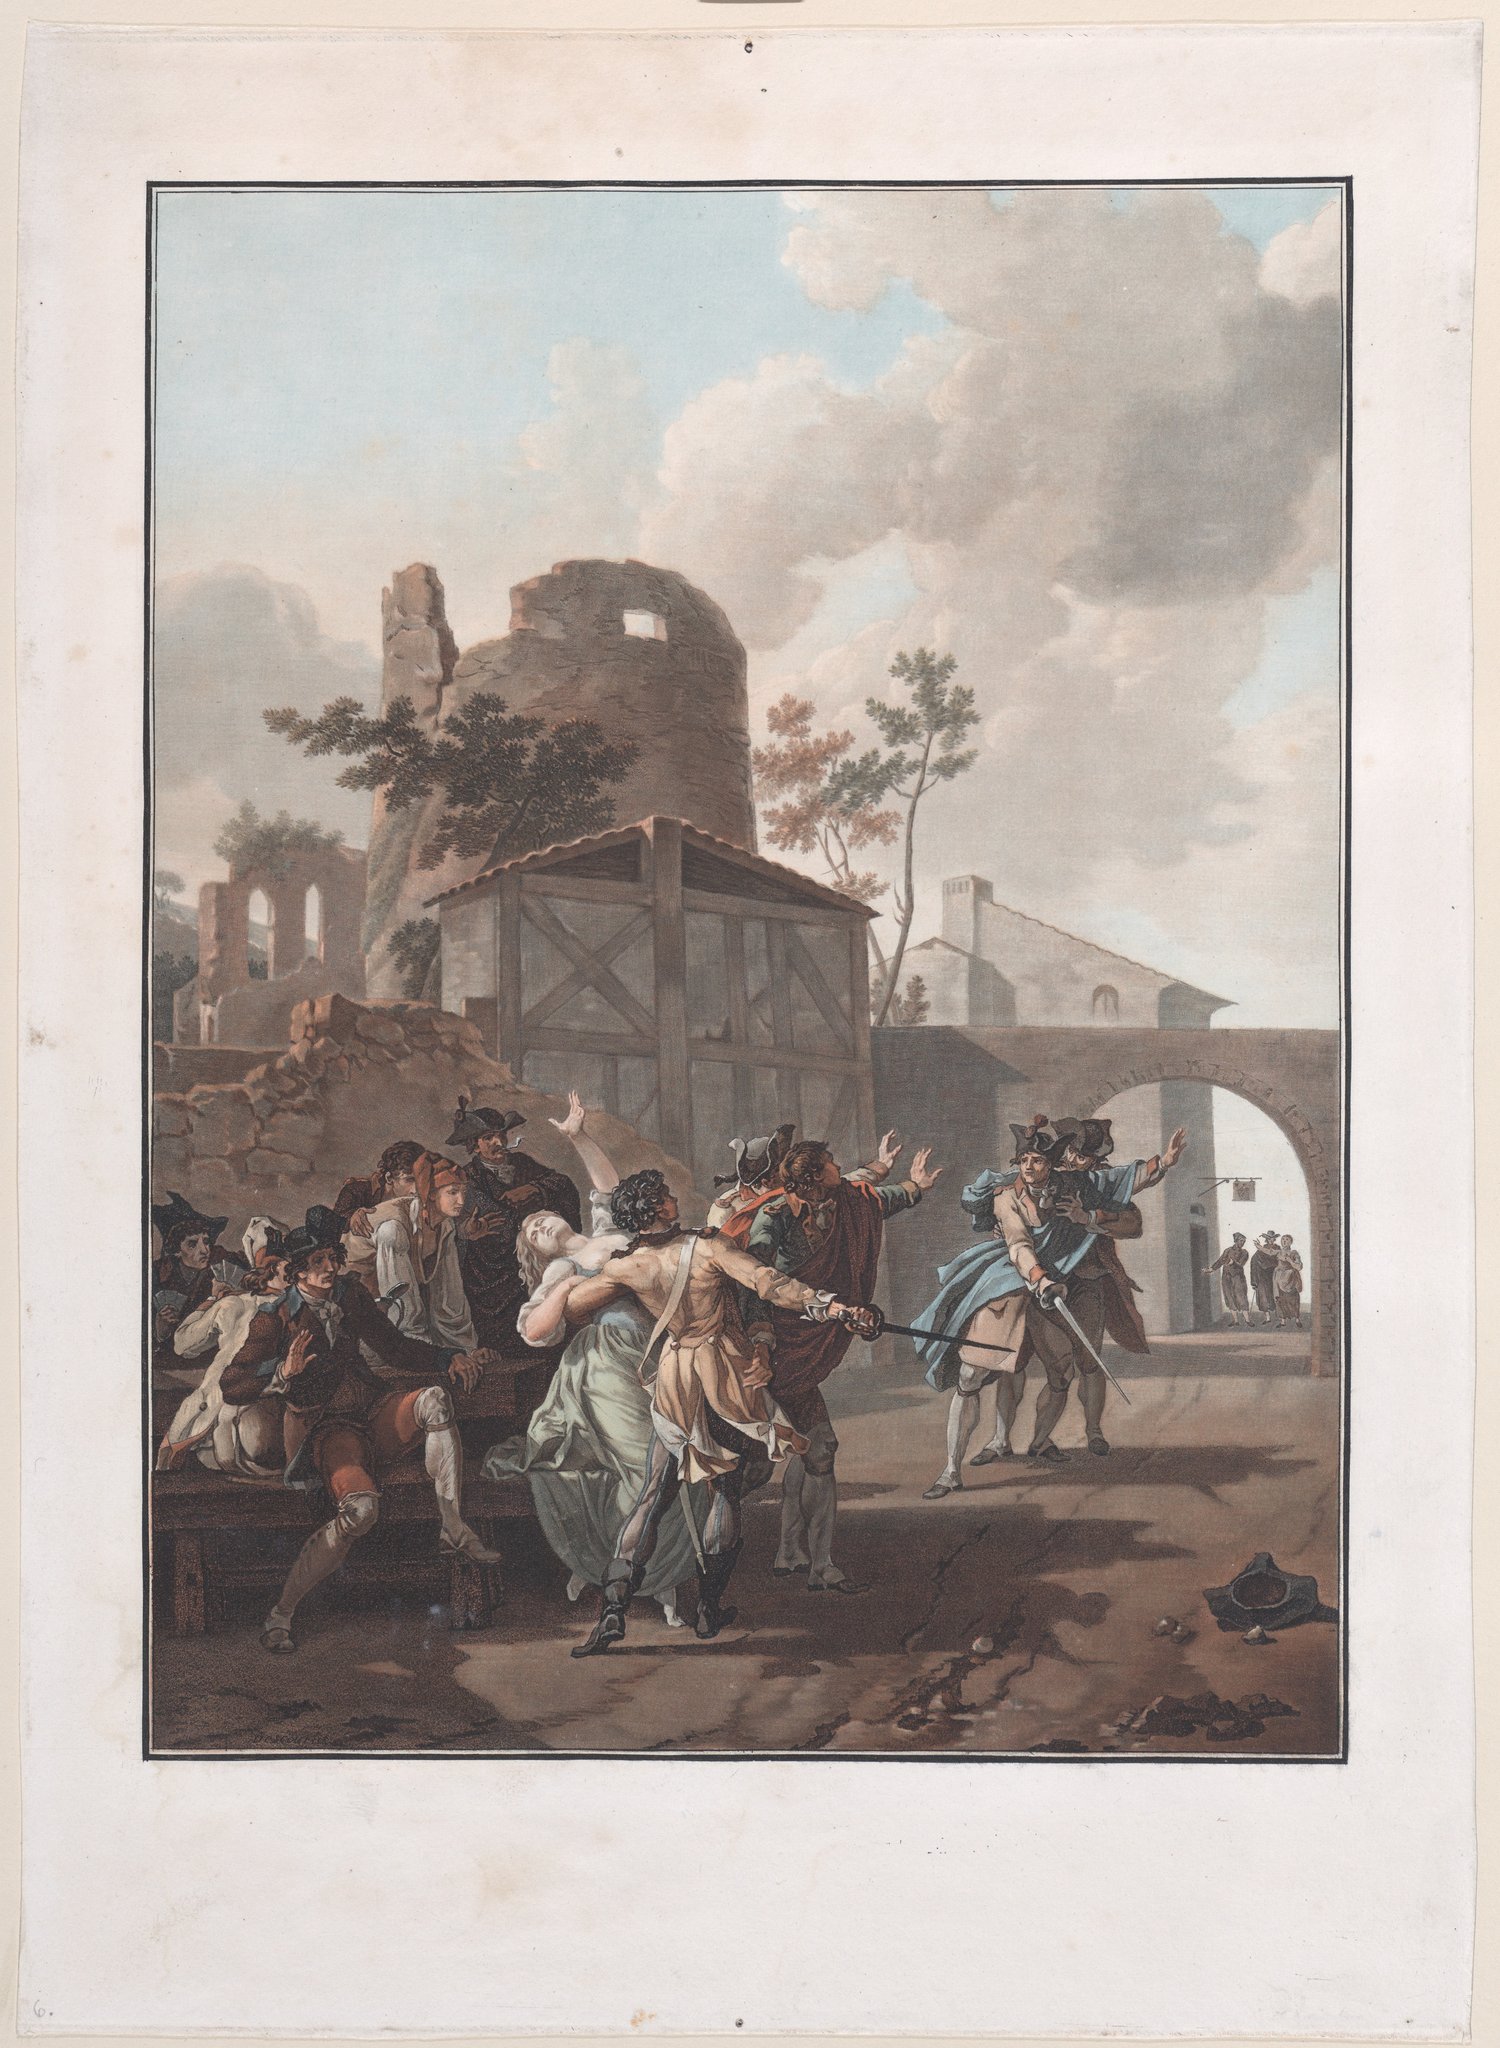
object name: print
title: The Brawl (La Rixe)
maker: charles melchior descourtis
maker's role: artist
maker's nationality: french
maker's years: 1753-1820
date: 1792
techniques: aquatint, engraving, etching